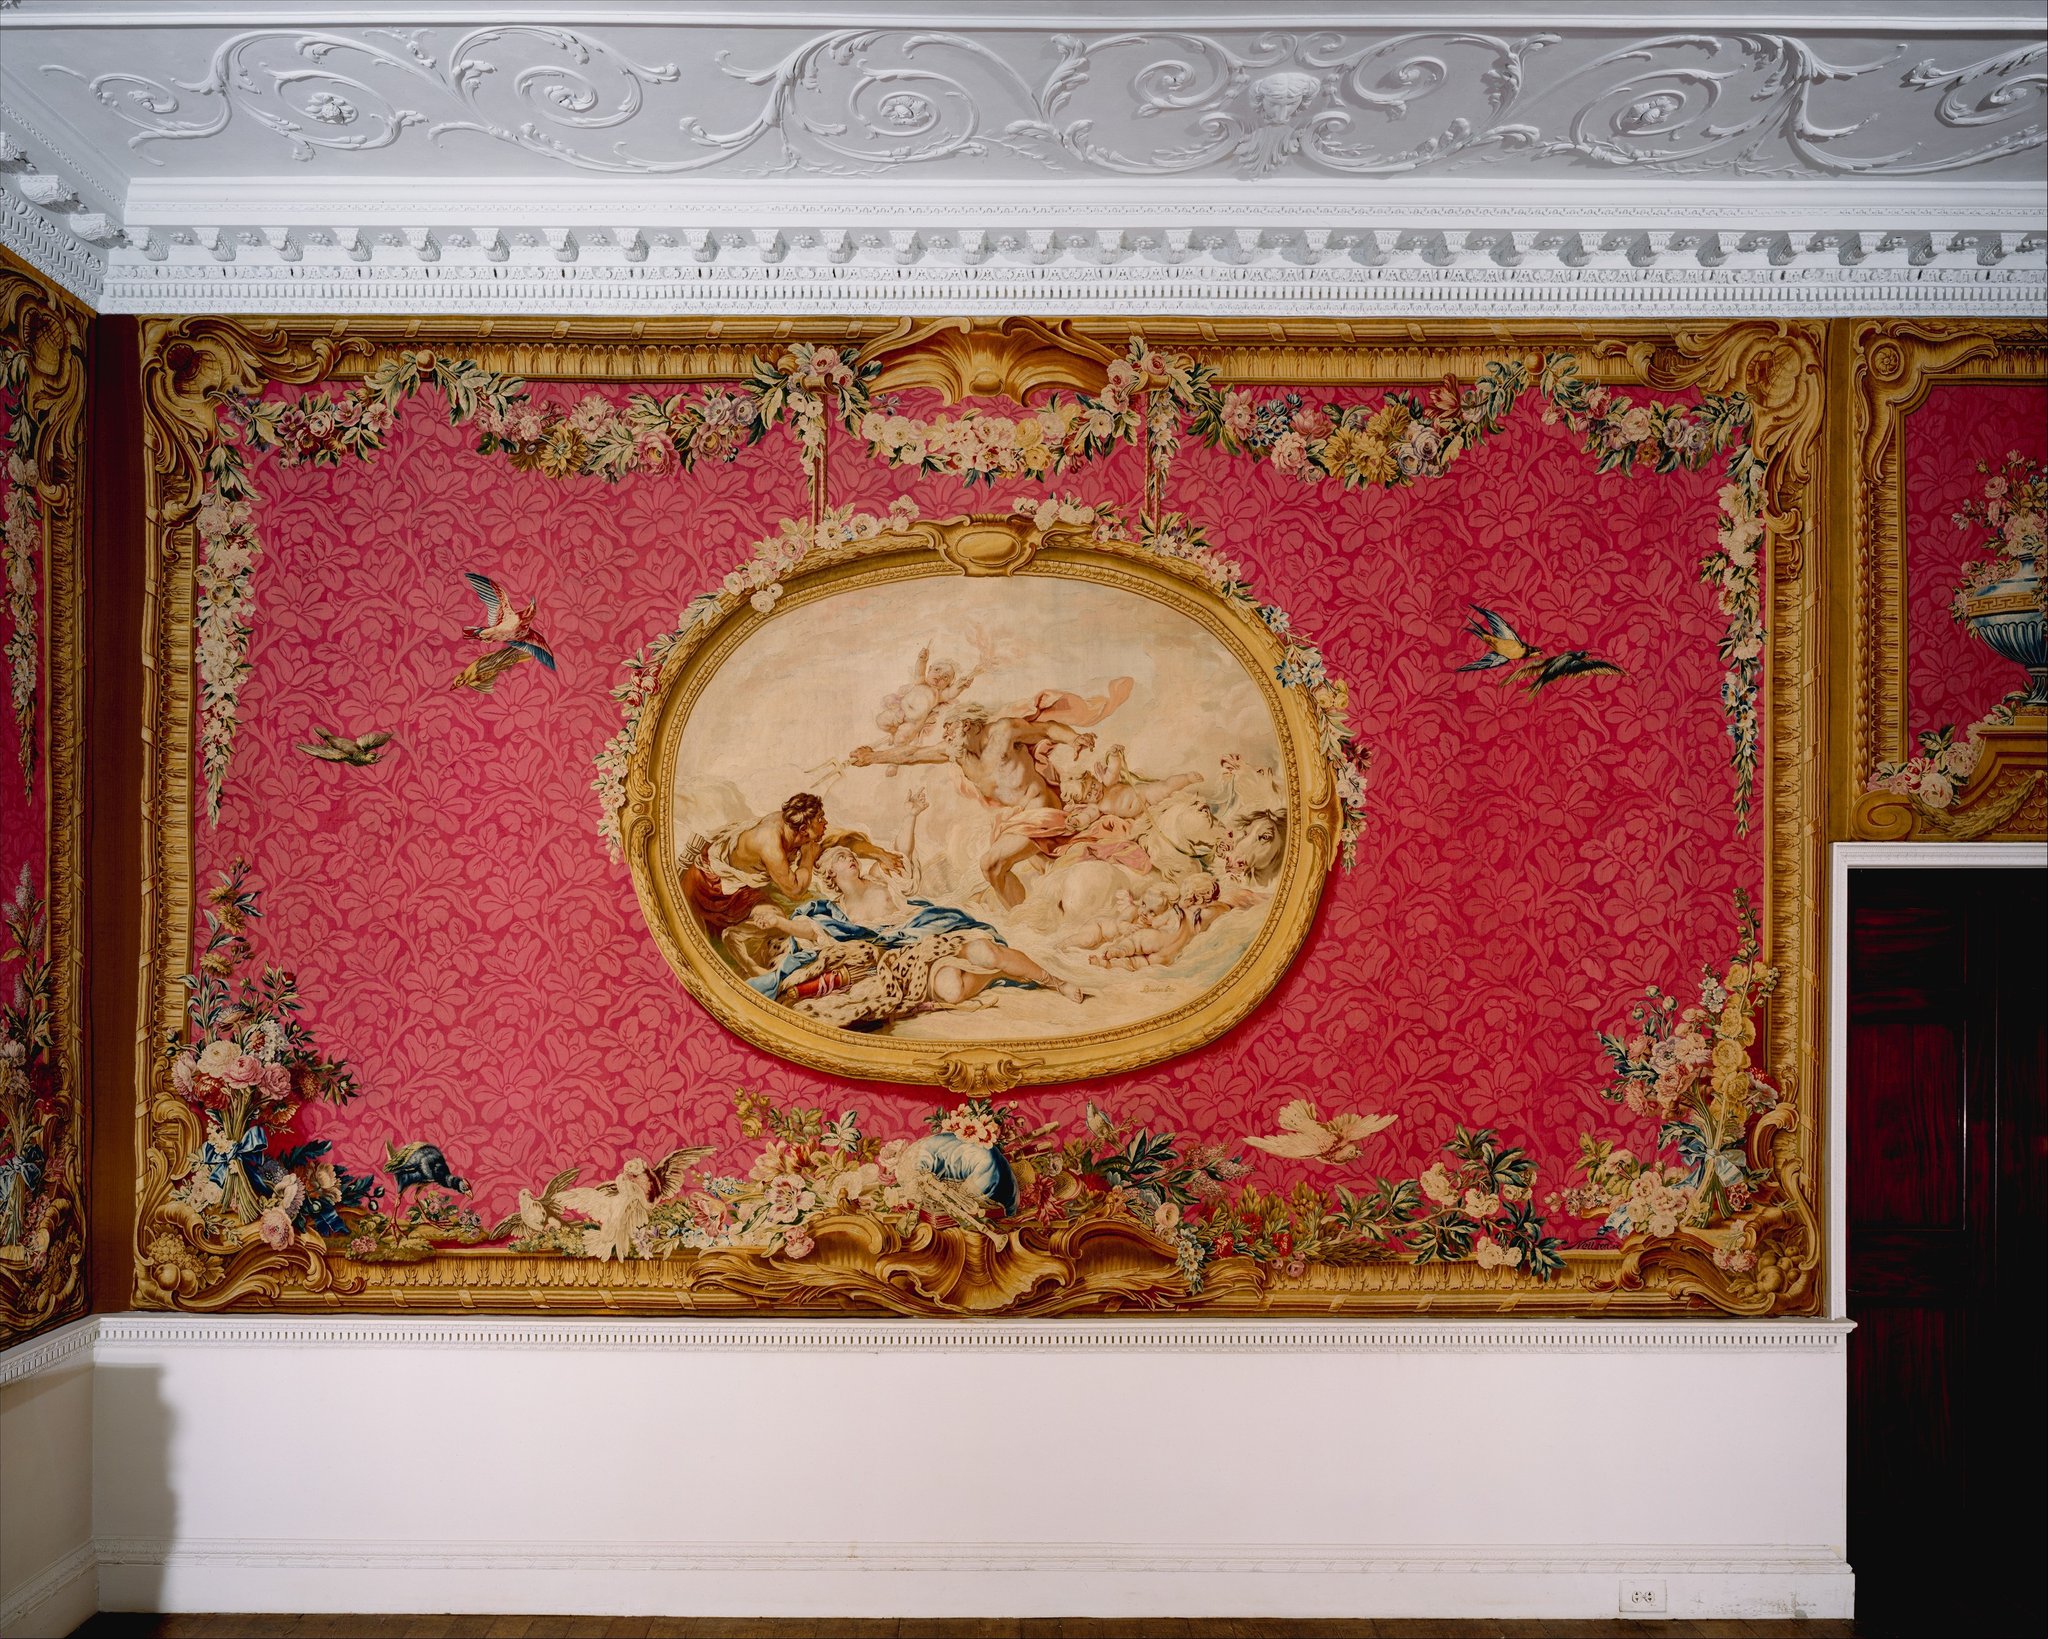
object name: tapestry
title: Allegory of Water (Neptune Rescuing Amymone)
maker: jacques germain soufflot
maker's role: designer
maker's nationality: french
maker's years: 1713-1780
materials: silk, wool